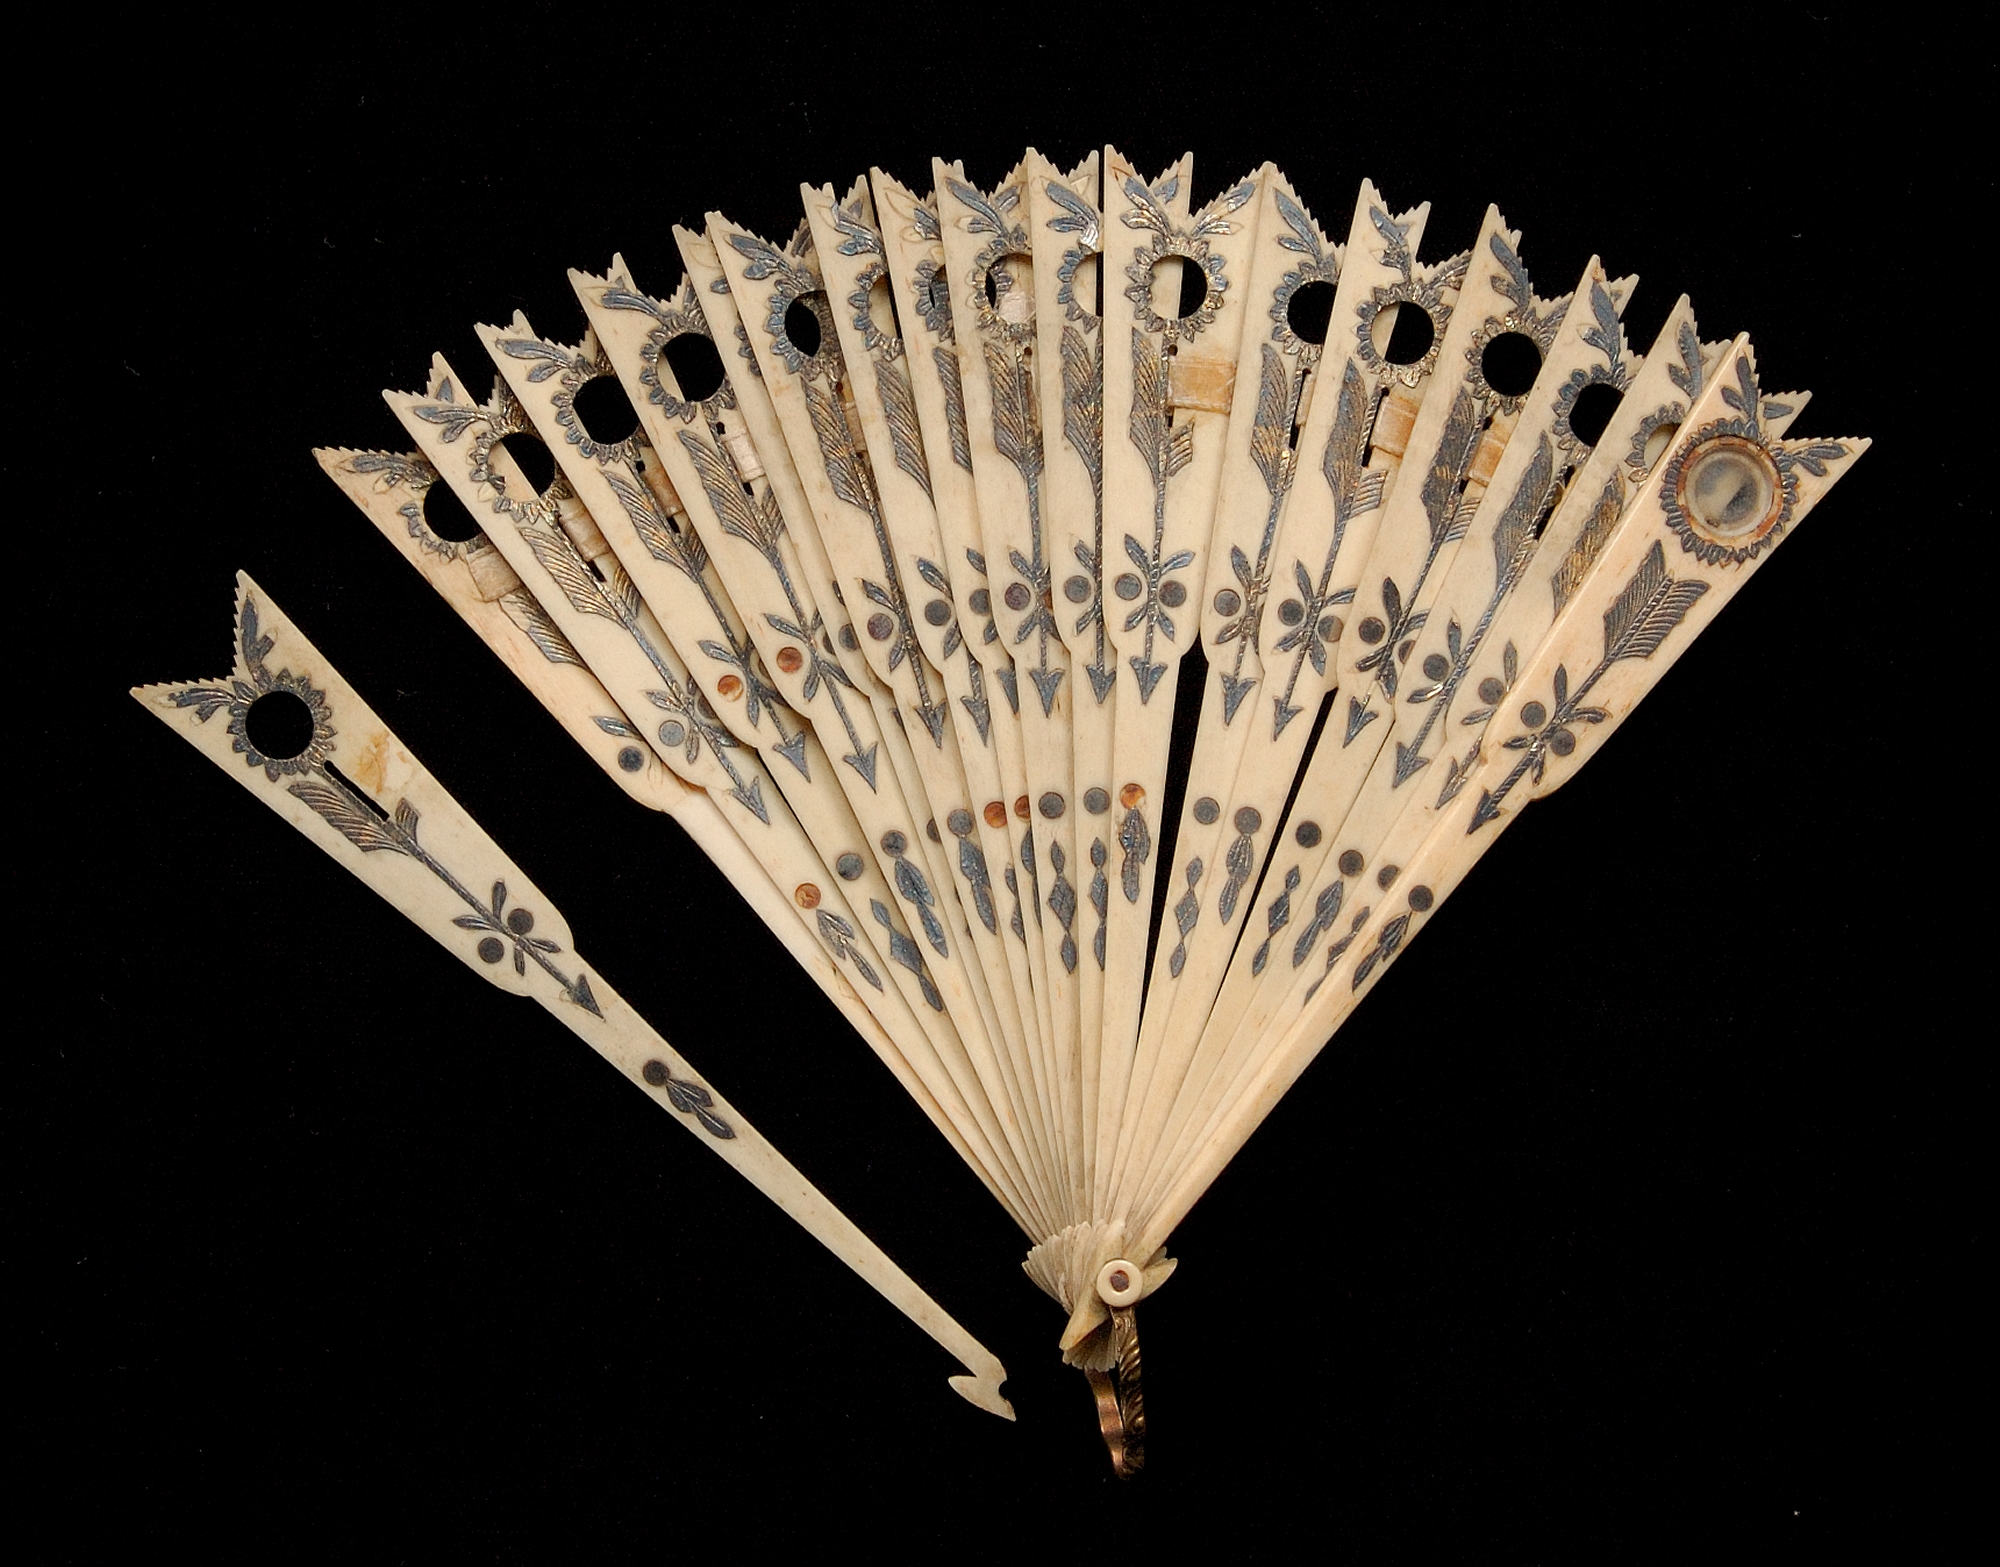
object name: brisé fan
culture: american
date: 1801-1825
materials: ivory, metal, silk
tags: arrows